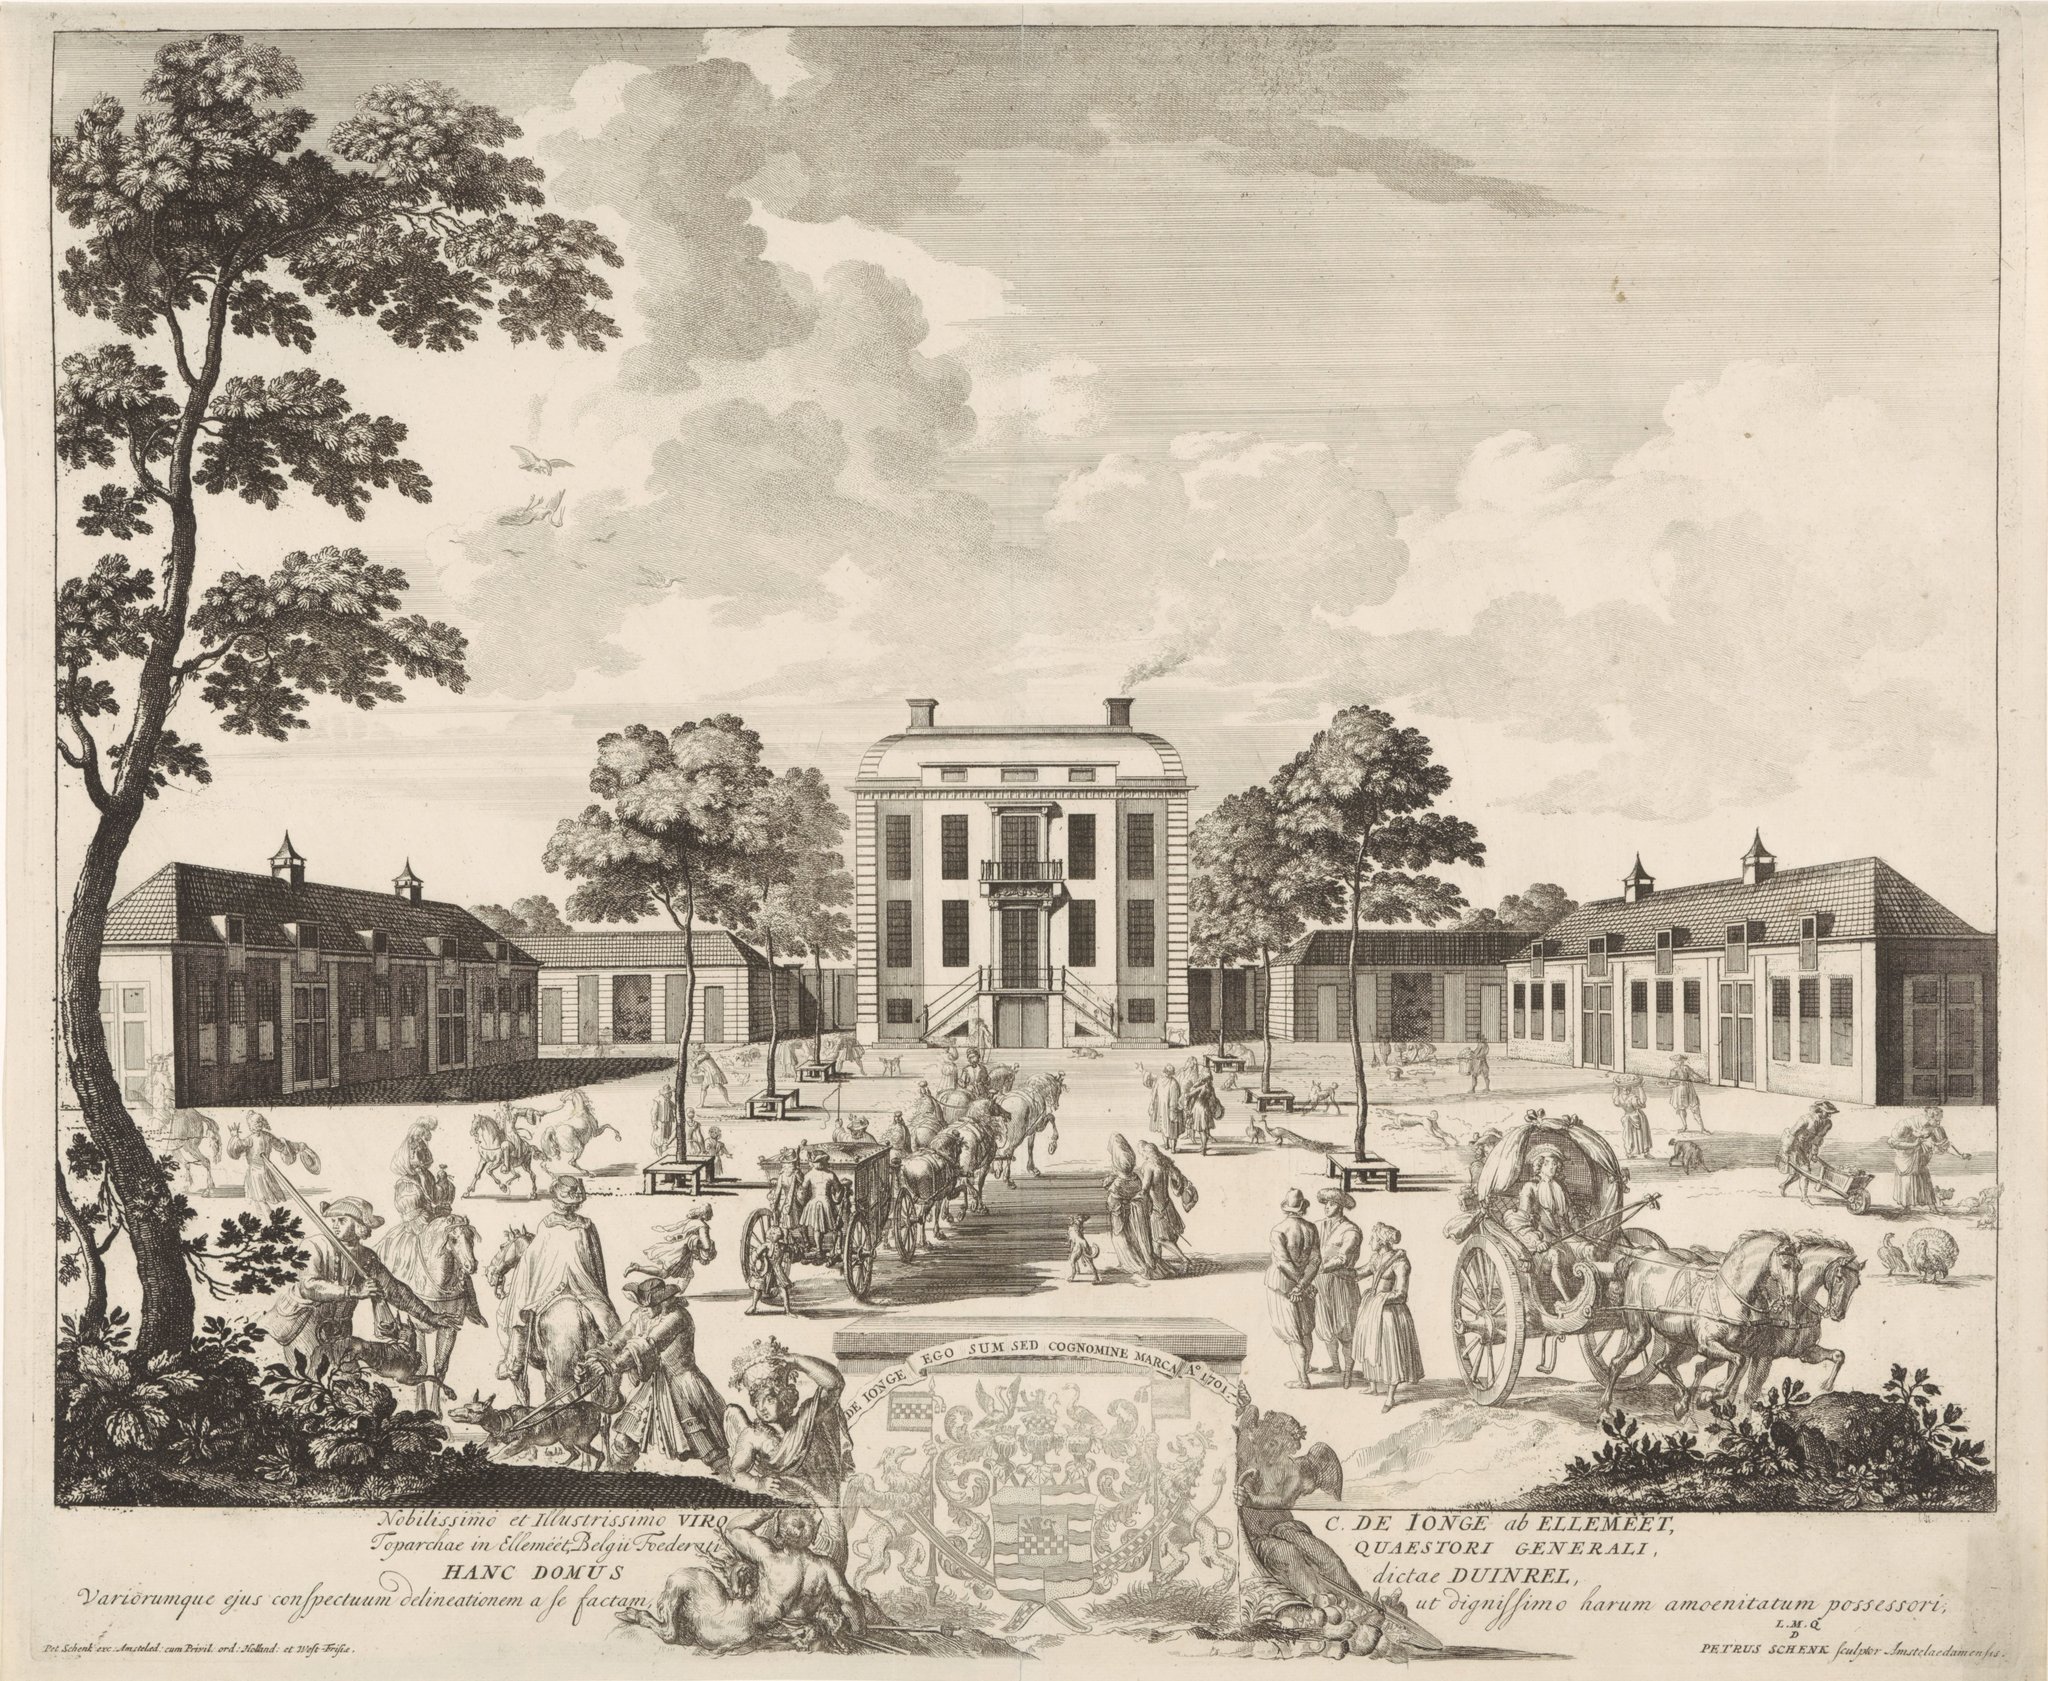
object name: print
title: Buitenplaats Duinrell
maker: pieter schenk (i)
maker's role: print maker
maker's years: 1660-1711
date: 1701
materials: paper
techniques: etching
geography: amsterdam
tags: four-wheeled, animal-drawn vehicle, e.g.: cab, carriage, coach, country-house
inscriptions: collector's mark: Lugt 2228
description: Gezicht op buitenplaats Duinrell met op de voorrgond mensen van divers pluimage en twee koetsen.